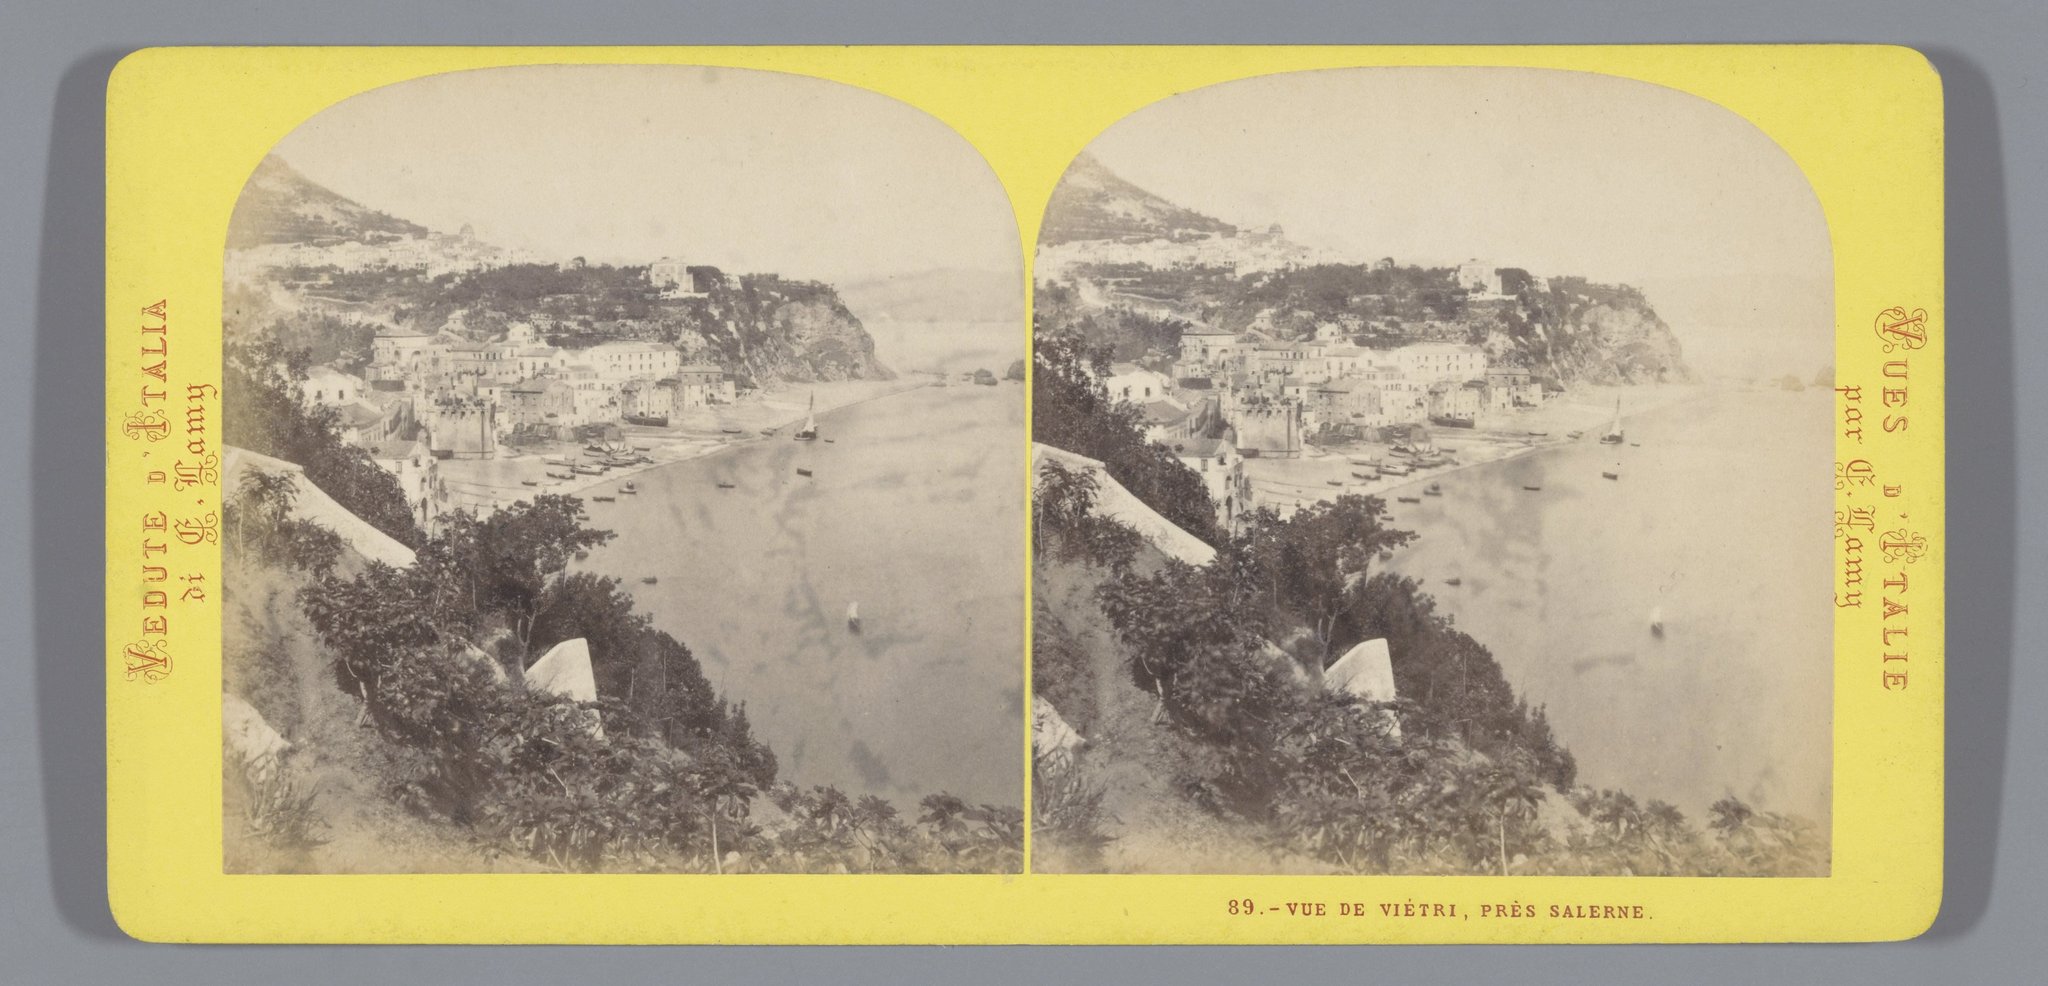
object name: stereograph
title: Vue de Viétri, près Salerne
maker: ernest eléonor pierre lamy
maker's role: publisher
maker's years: 1828-1900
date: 1861-1878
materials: cardboard, paper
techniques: albumen print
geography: vietri sul mare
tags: gulf, bay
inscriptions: number: ‘89.’